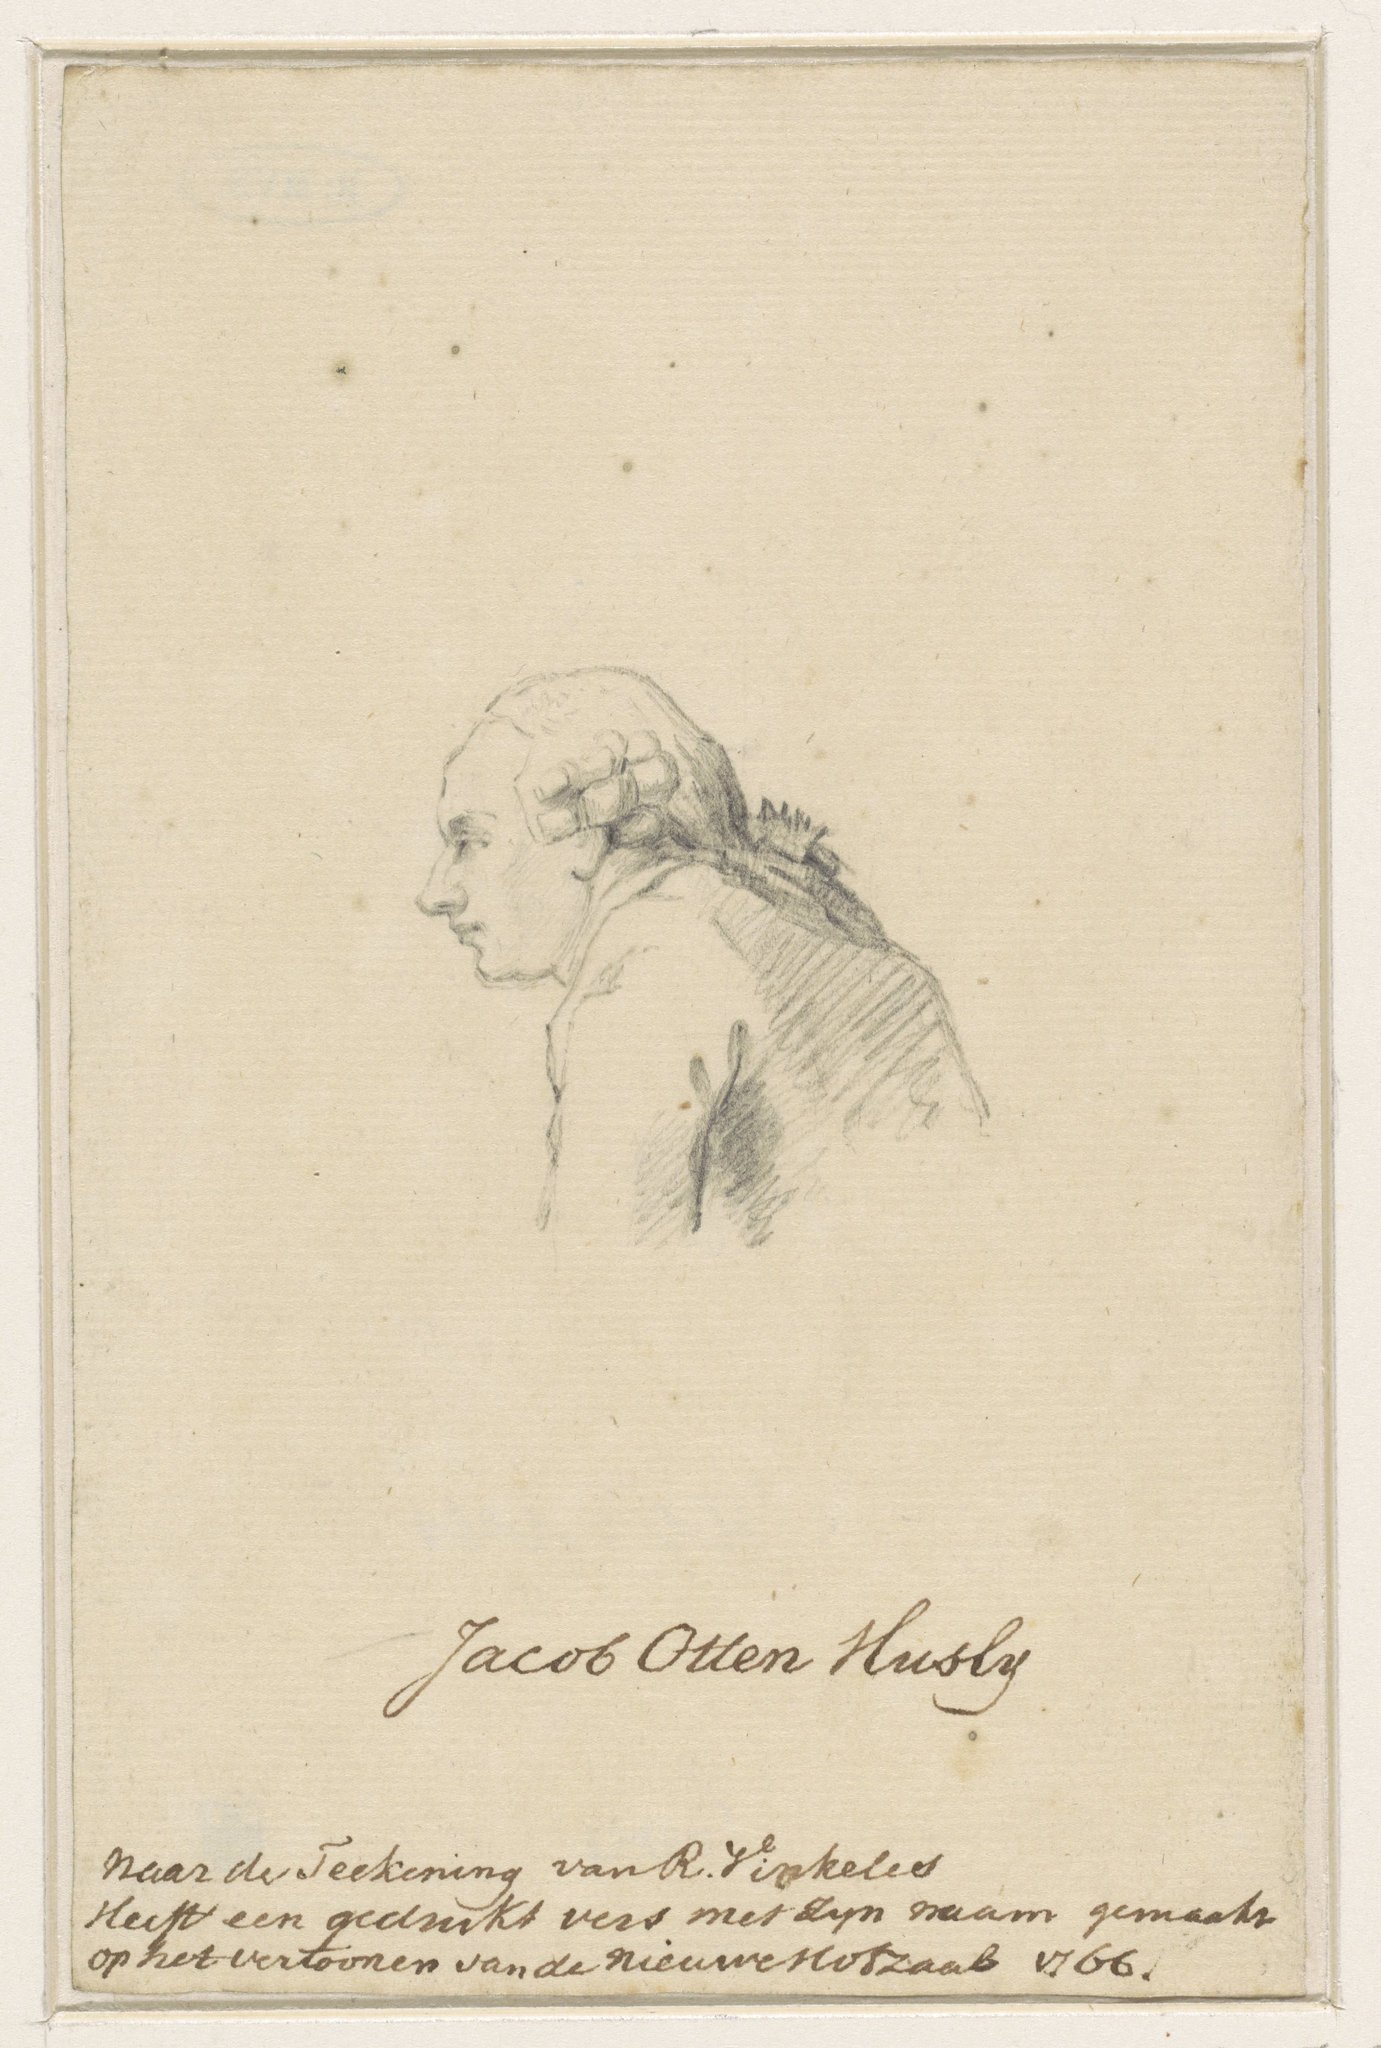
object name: drawing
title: Portret van (Hans) Jacob Otten Husly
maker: gerrit lamberts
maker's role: bookseller, draughtsman, print maker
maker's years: 1776-1850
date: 1766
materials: paper, pencil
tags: draughtsman, jacob otten huslij, historical persons, portrait, self-portrait of painter, portrait, self-portrait of artist, portrait, self-portrait of draughtsman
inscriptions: date